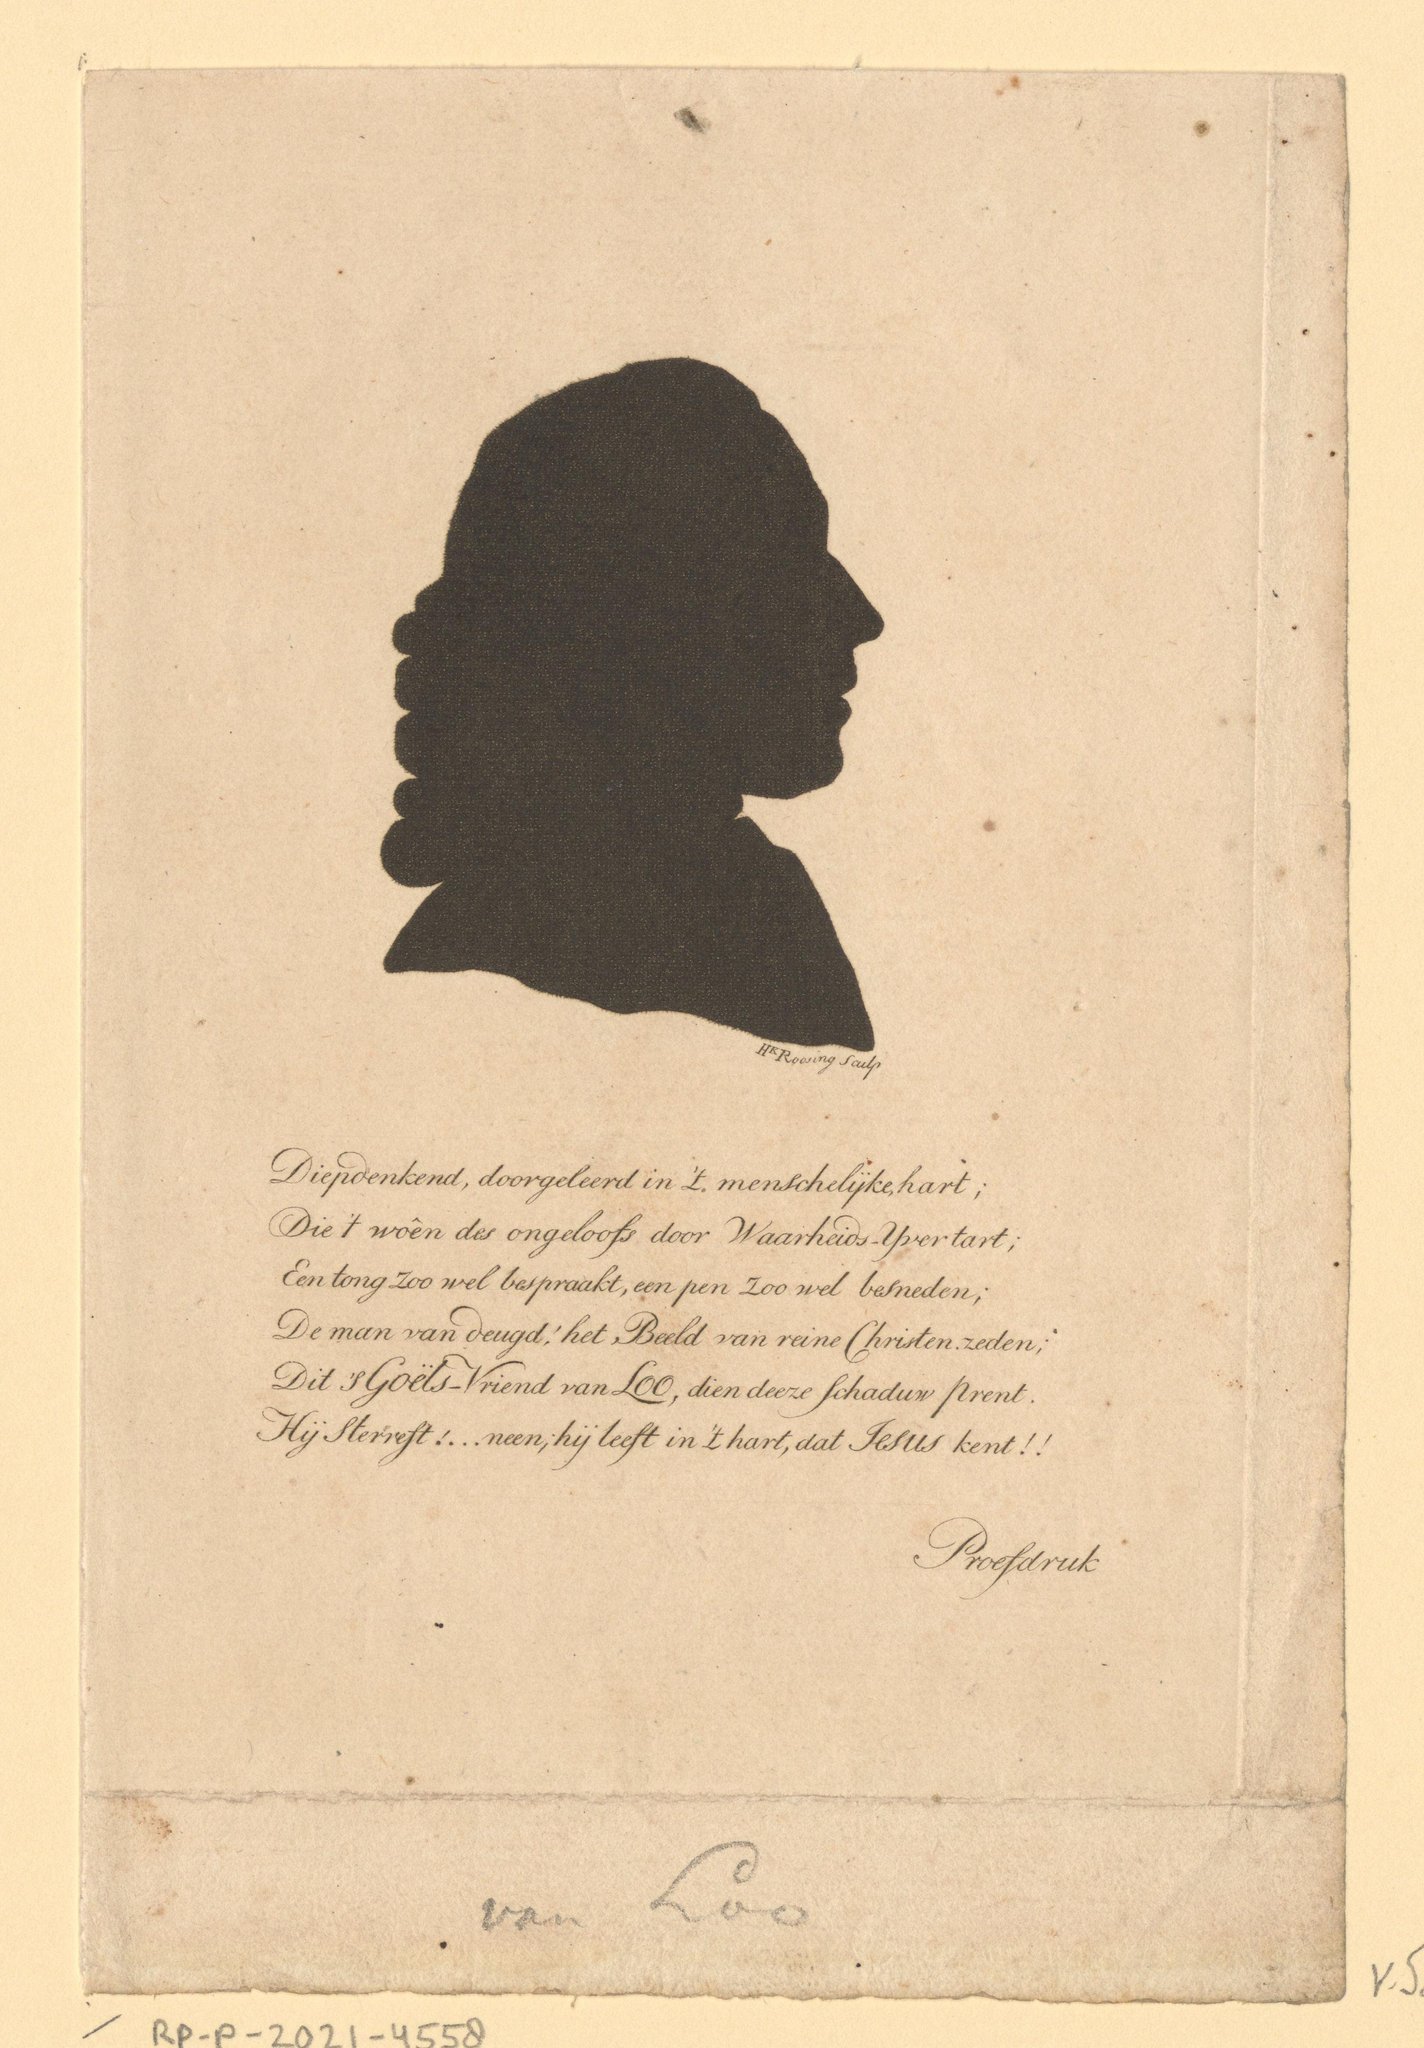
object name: print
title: Silhouetportret van Jacob van Loo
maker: hendrik roosing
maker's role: print maker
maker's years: 1763-1826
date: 1799-1801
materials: paper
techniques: engraving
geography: netherlands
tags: historical persons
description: Met zesregelig lofdicht in het Nederlands, ter gelegenheid van het overlijden van Van Loo. Rechtsonder vermeld: Proefdruk.